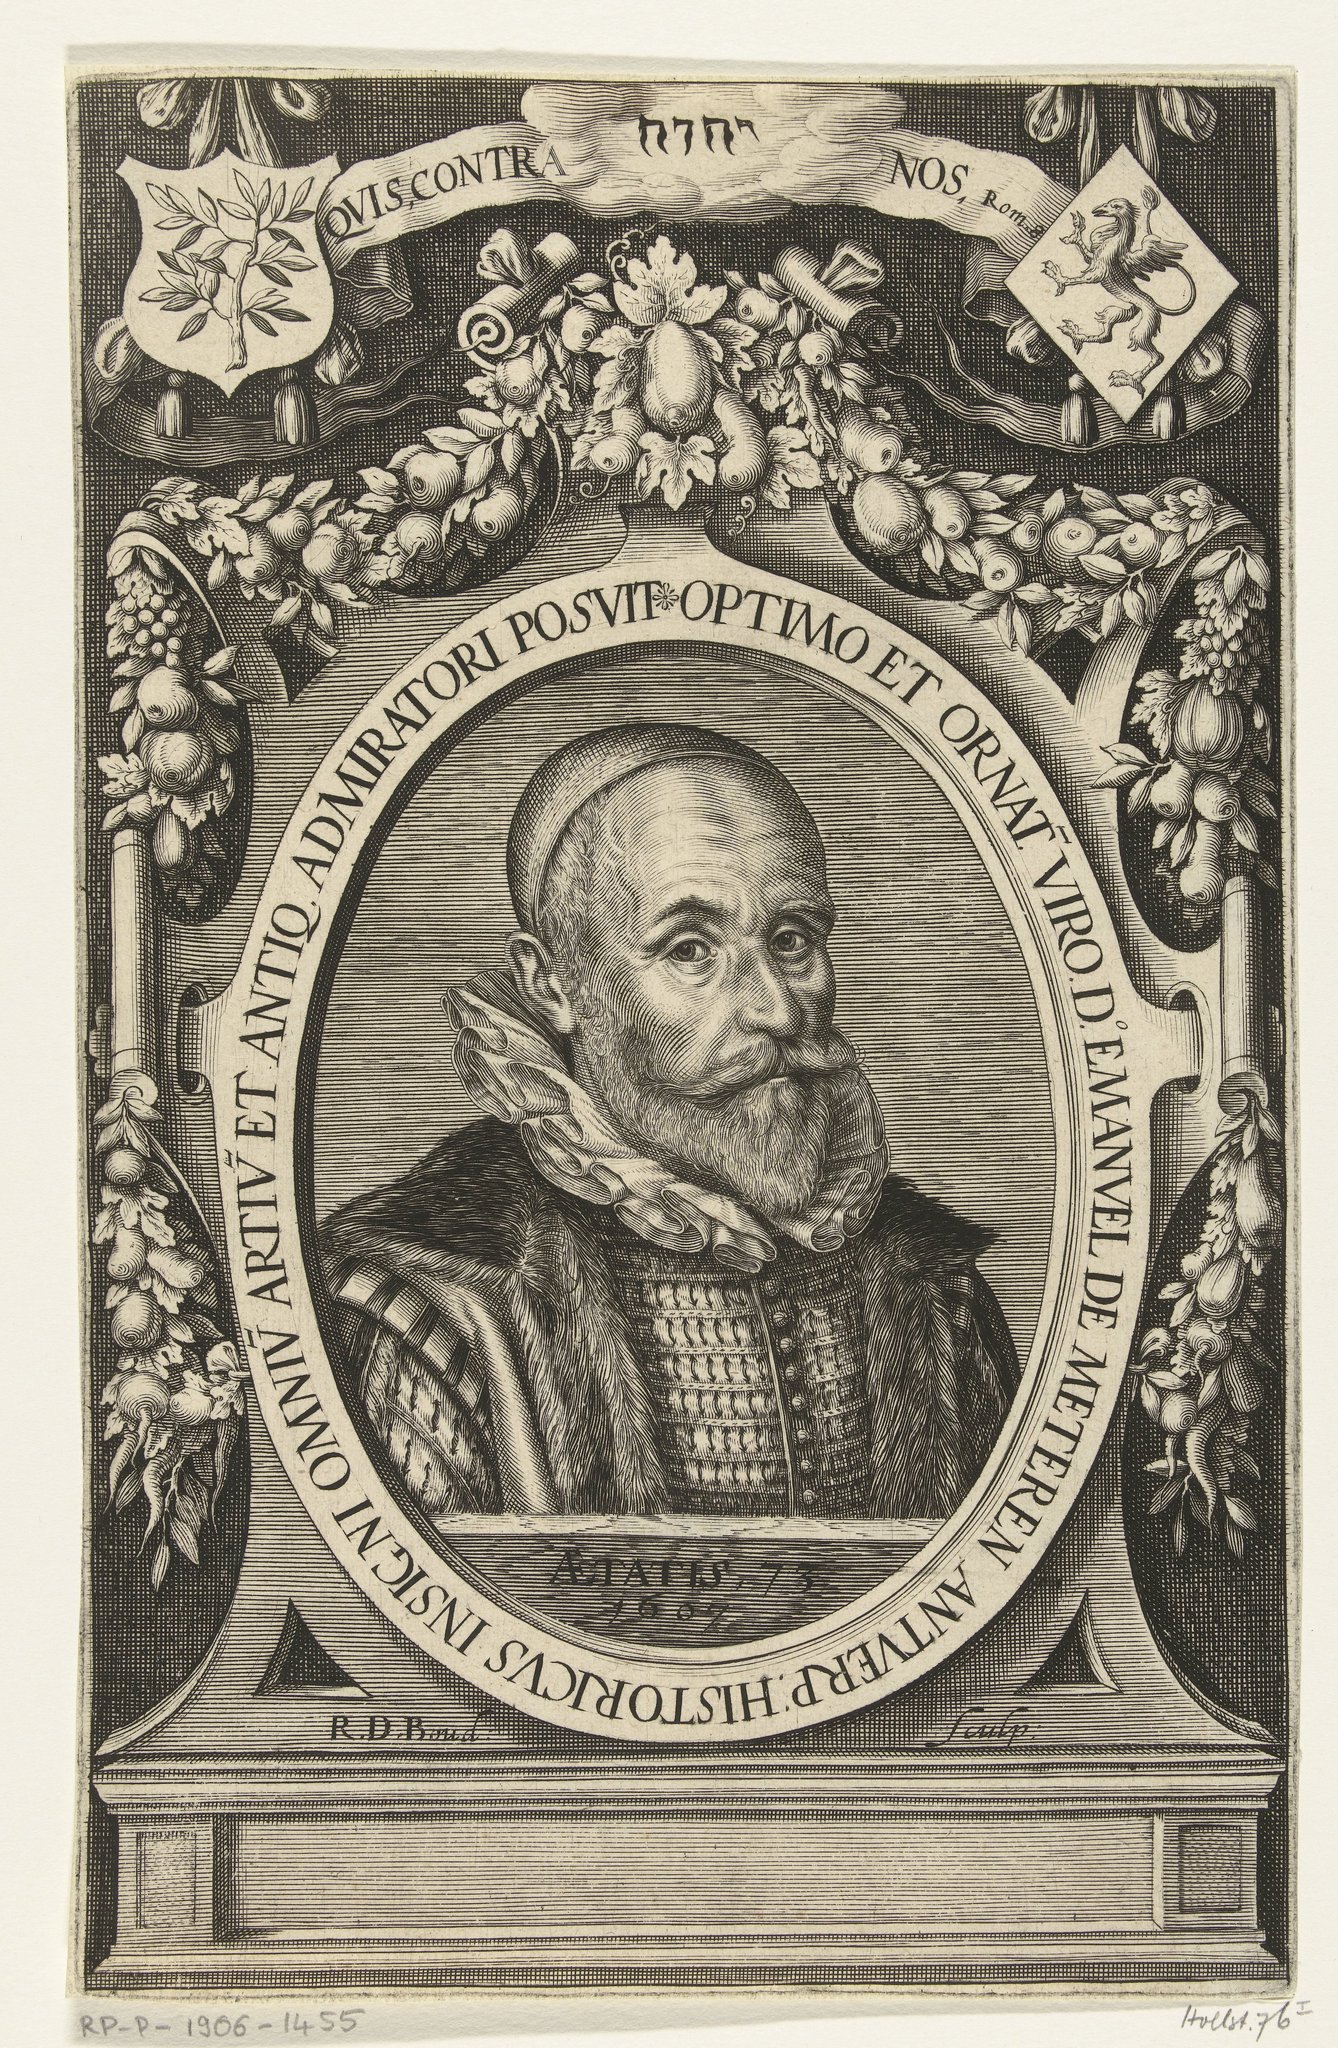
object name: print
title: Portret van Emanuel van Meteren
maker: robert de baudous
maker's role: print maker, publisher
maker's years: 1574-1659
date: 1607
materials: paper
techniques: engraving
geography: amsterdam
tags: london, emanuel van meteren, historical disciplines; philology (+ portrait of scholar, scientist), (diplomat) presenting credentials, merchant, salesman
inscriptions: collector's mark: Lugt 2228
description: Portret van Emanuel van Meteren, koopman in Londen en historicus in Antwerpen, op 73-jarige leeftijd. Buste naar rechts, in ornamentale omlijsting met randschrift, gedecoreerd met guirlandes.